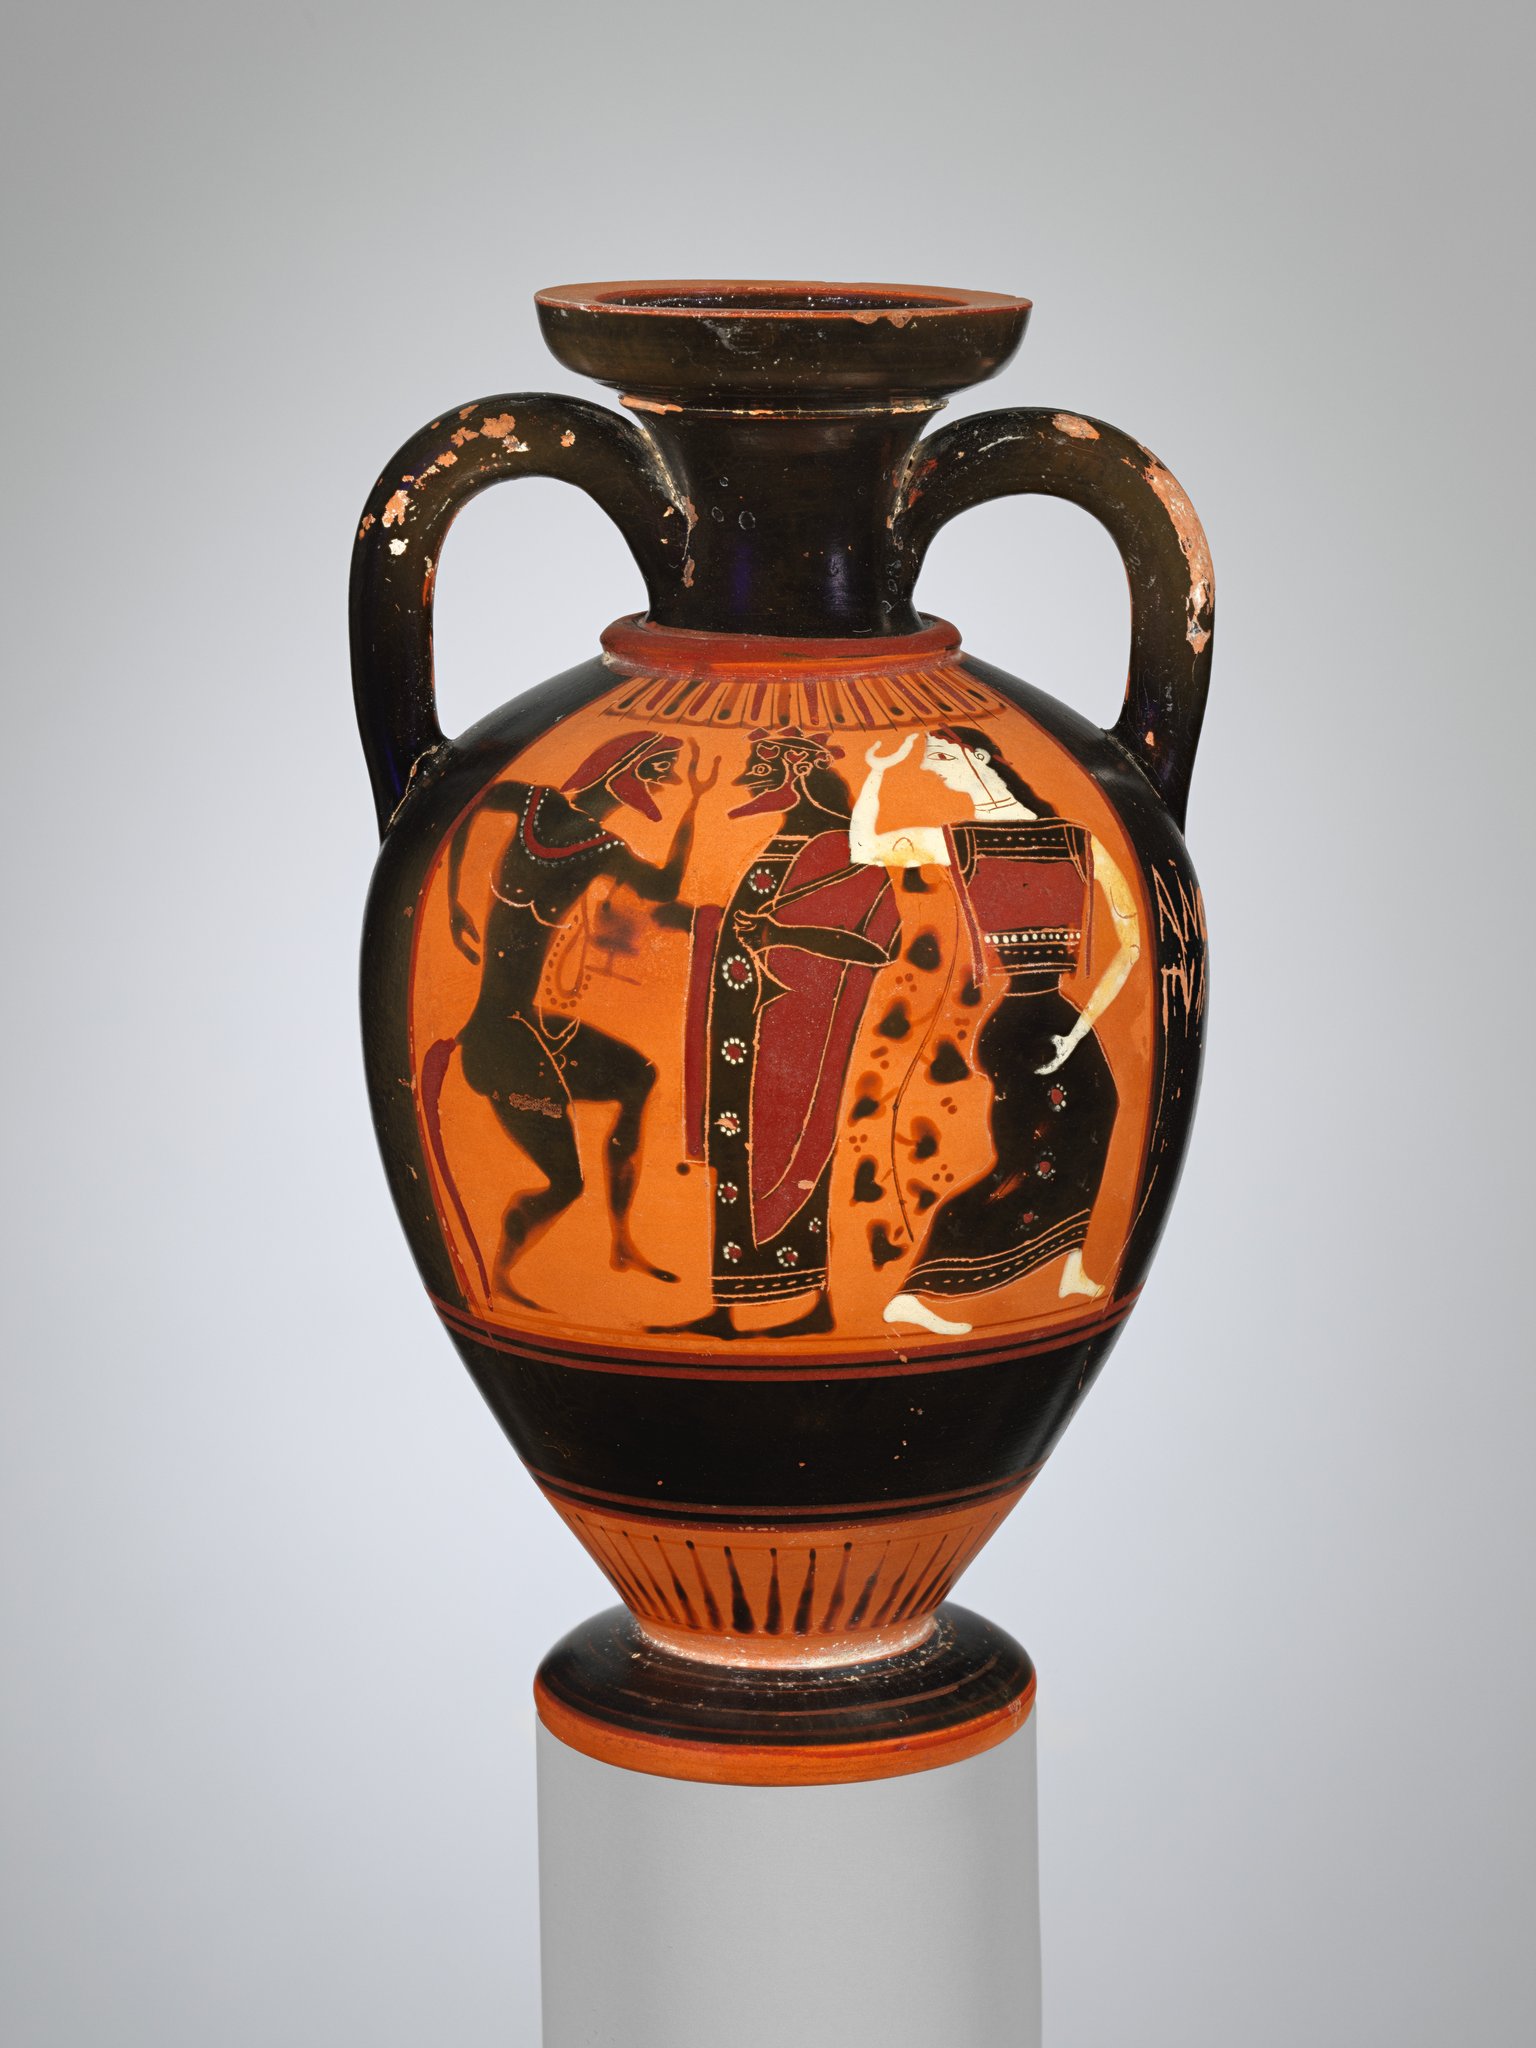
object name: neck amphora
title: Terracotta neck-amphora (jar)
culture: greek, attic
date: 550-540 BCE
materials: terracotta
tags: dionysus,maenads,satyrs